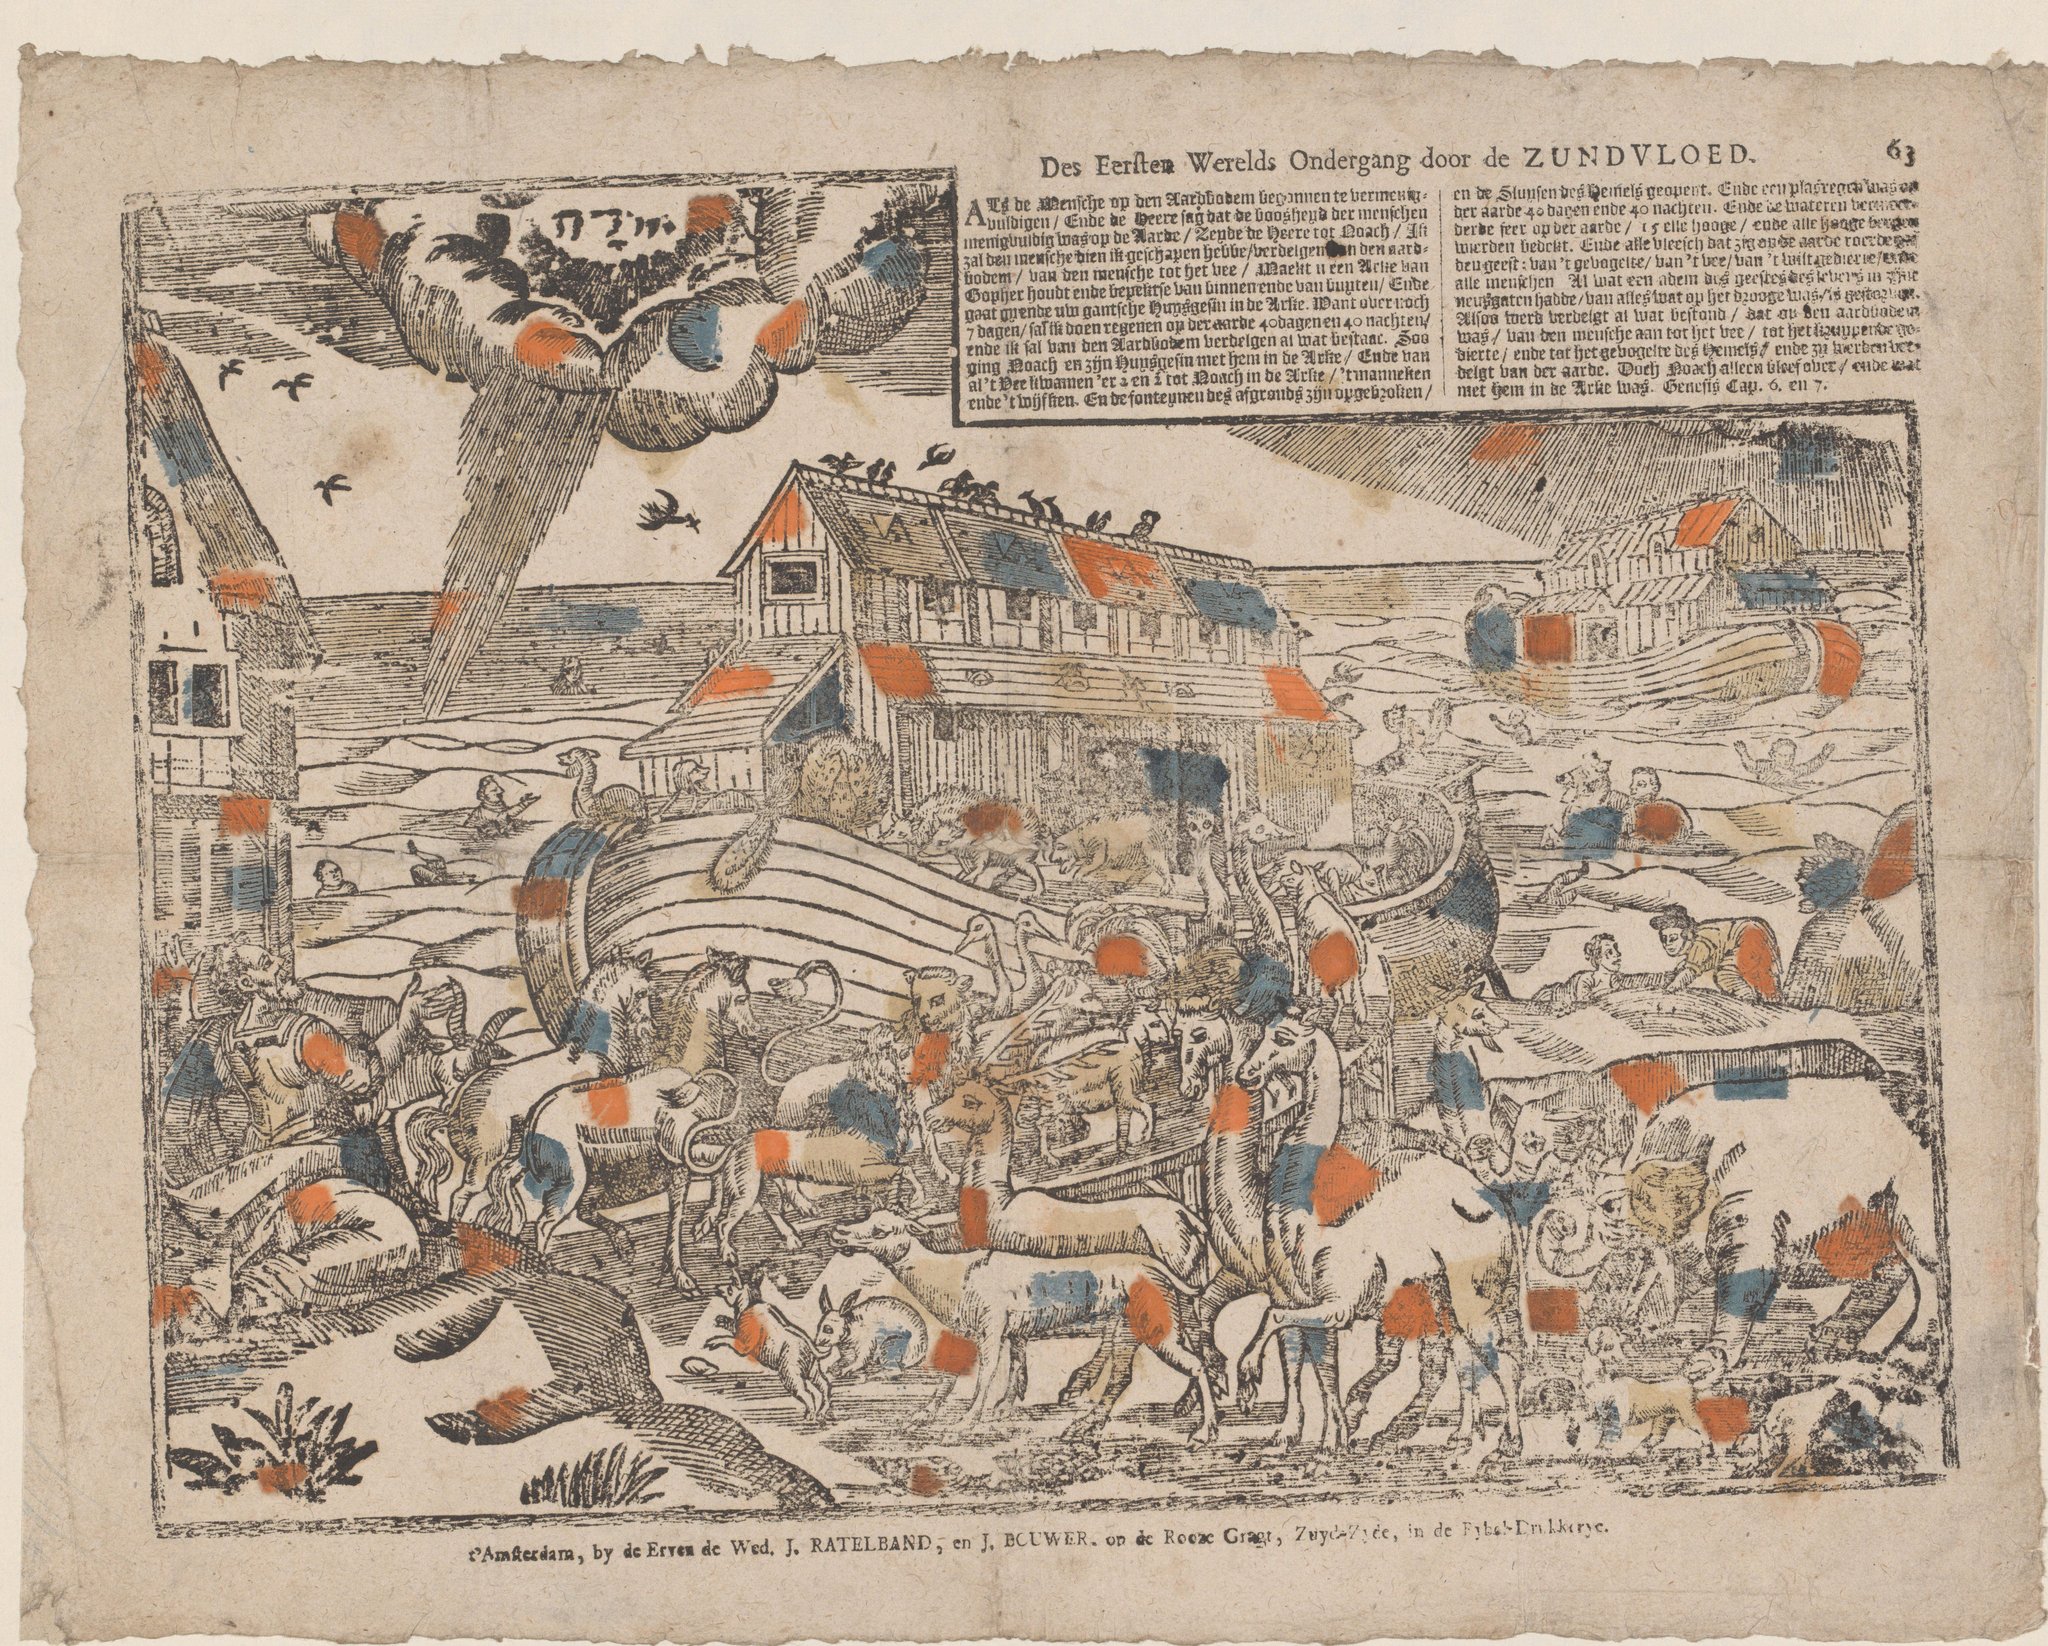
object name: popular print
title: Des eersten werelds ondergang door de zundvloed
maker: Anonymous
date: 1550-1650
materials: paper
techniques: colour, letterpress printing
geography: amsterdam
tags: the flood and destruction of mankind ~ story of noah (genesis 7:10 - 8:17), the building of the ark, and the embarkation (genesis 7:5-9)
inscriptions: collector's mark: Lugt 2760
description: Blad met een grote voorstelling van dieren die aan boord gaan van de ark van Noach. Op de achtergrond de Zondvloed. Rechtsboven een uitsparing voor twee kolommen tekst uit Genesis 6 en 7. Genummerd rechtsboven: 63.